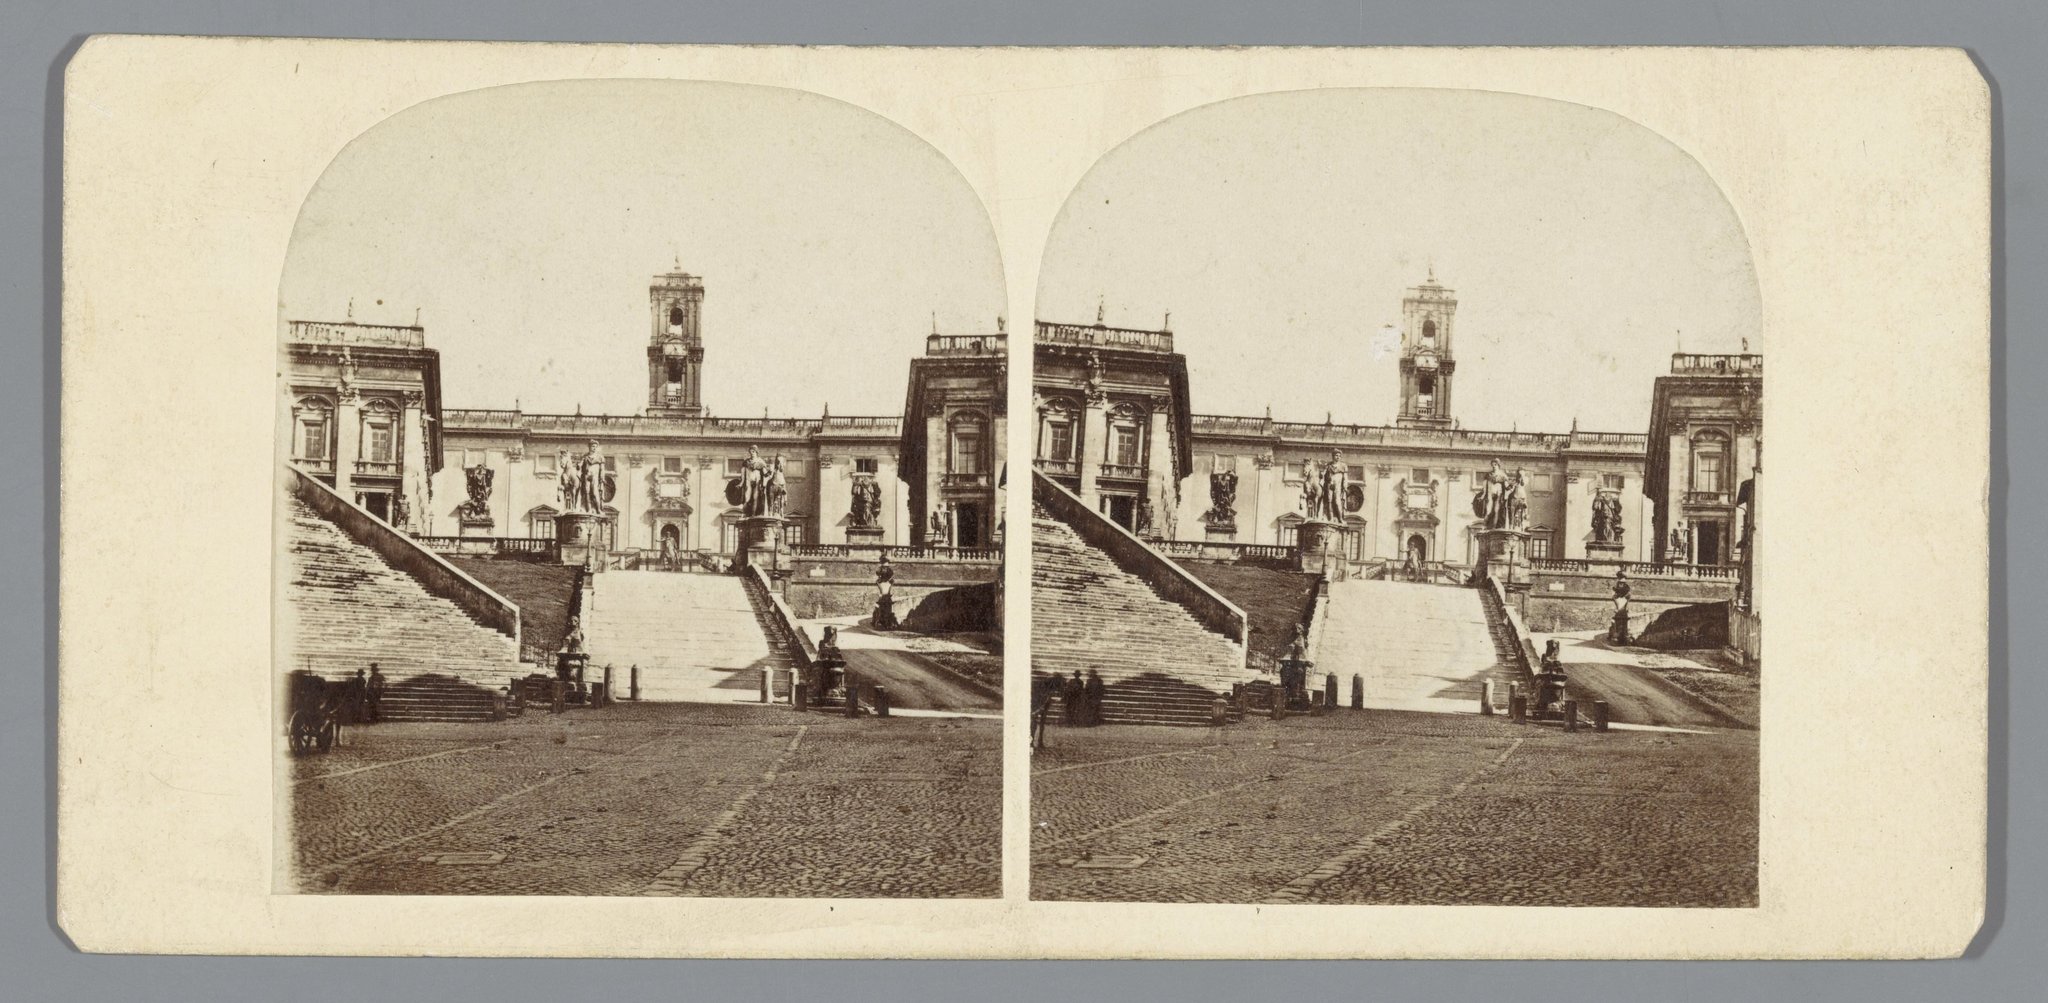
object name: stereograph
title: Vue du Capitole Rome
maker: Anonymous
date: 1868-1890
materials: cardboard, paper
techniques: albumen print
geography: rome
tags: front steps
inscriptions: inscription: ‘1,50’, inscription: ‘Vue Du Capitole/ Rome’, inscription: ‘400-’